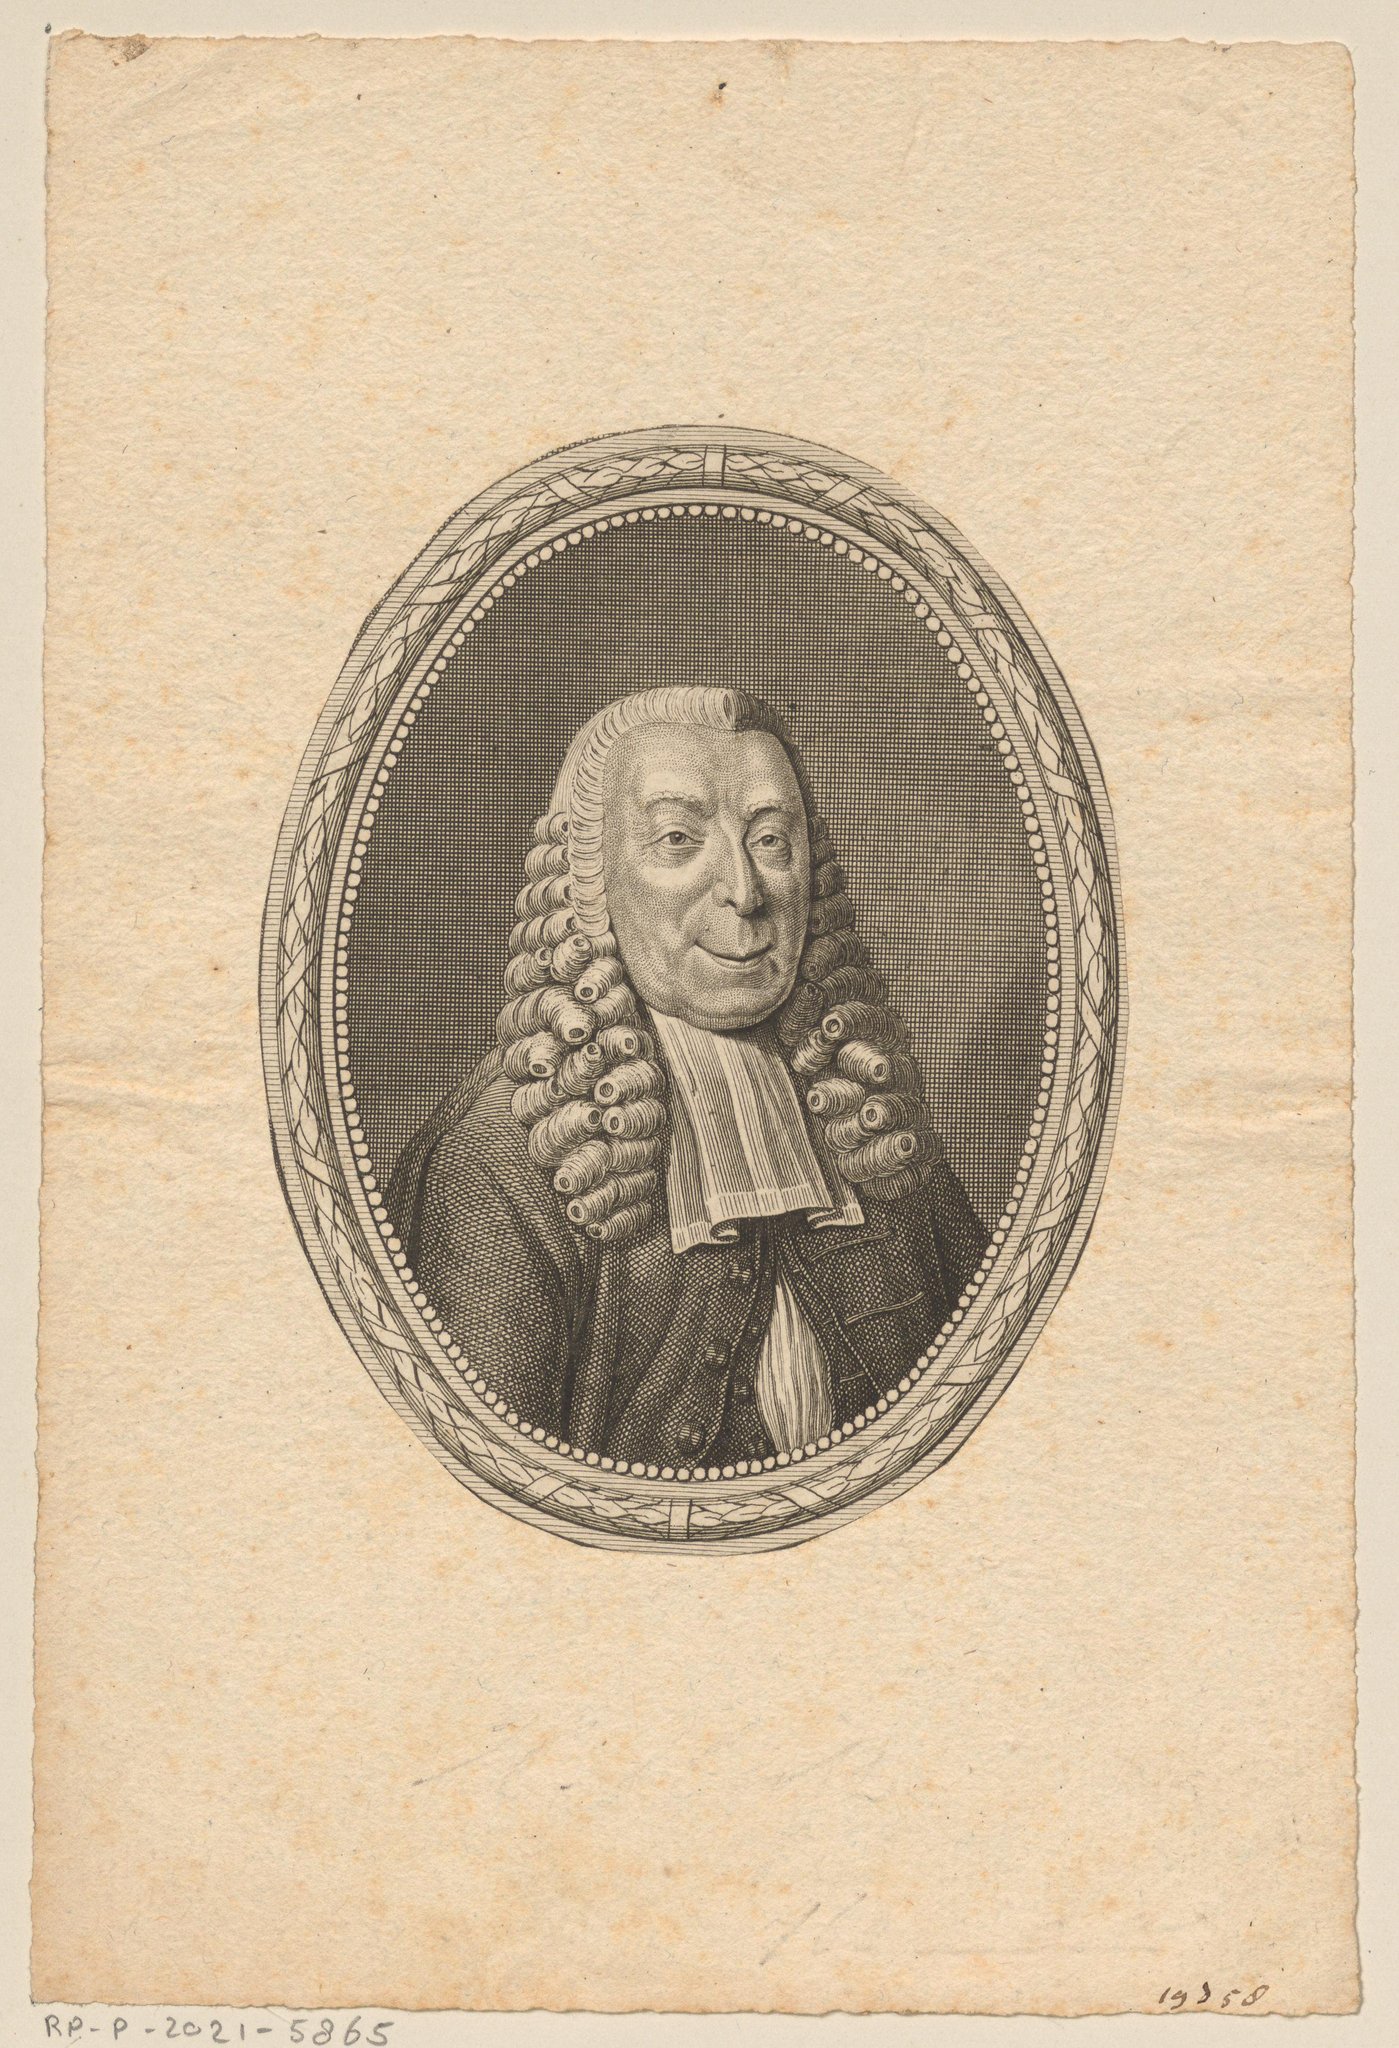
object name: print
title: Portret van Hendrik Danielsz. Hooft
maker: Anonymous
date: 1769-1799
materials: paper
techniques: etching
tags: hendrik danielsz. hooft, mayor, burgomaster, historical persons